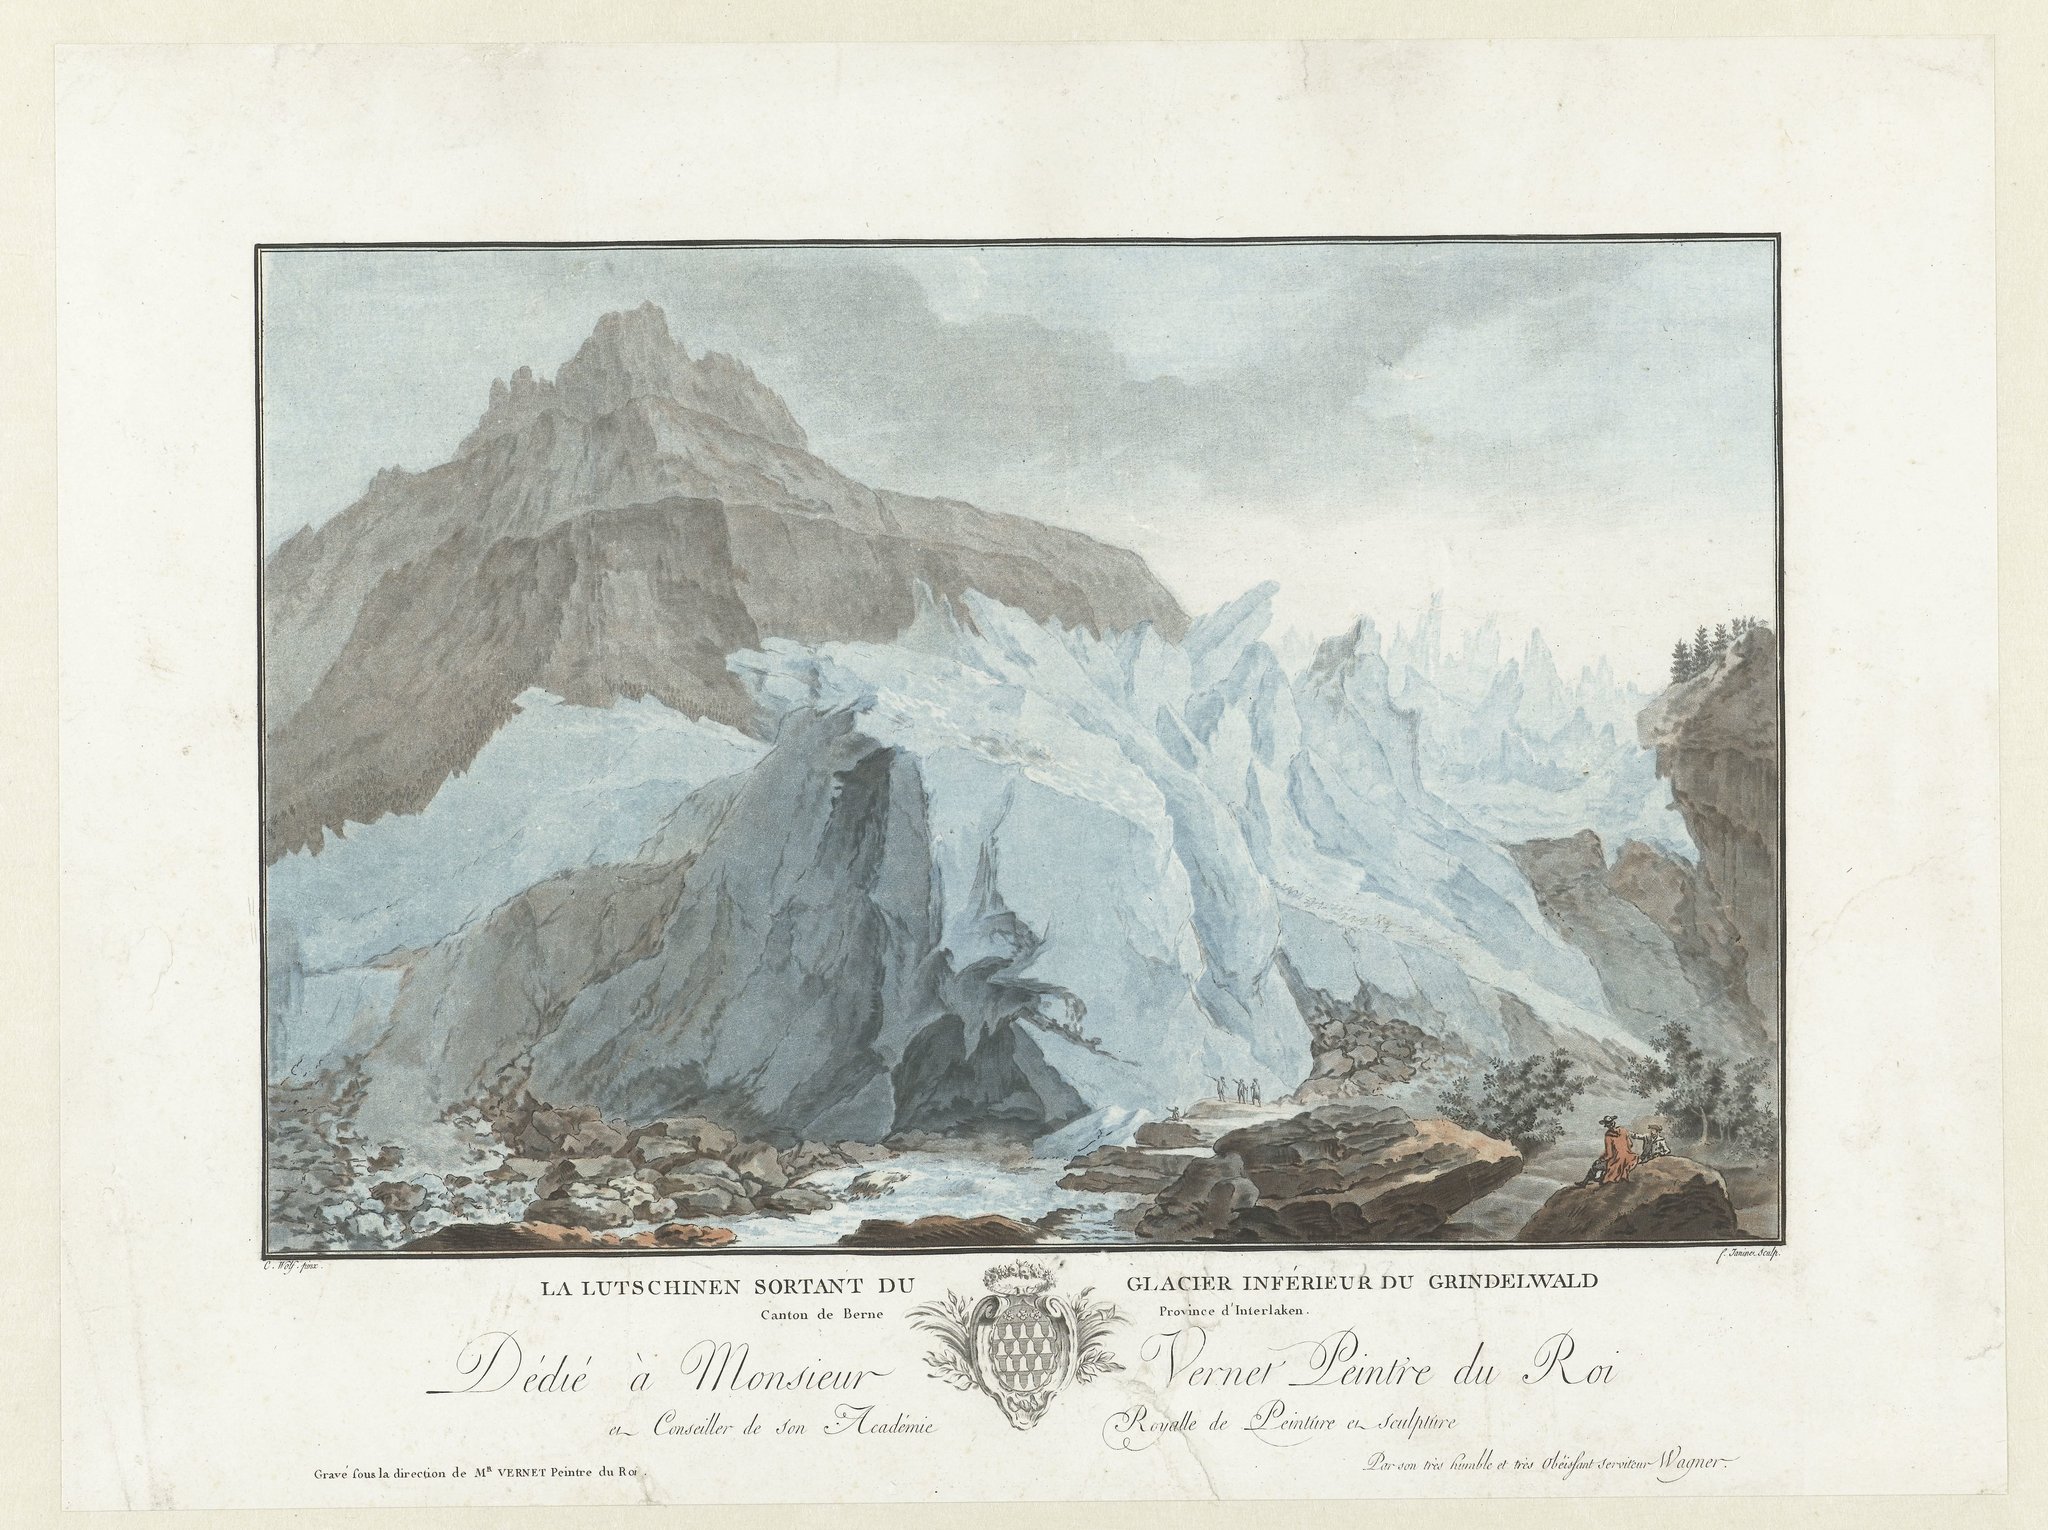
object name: print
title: Vues remarquables des montagnes de la Suisse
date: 1762-1785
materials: paper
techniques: etching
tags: glacier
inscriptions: collector's mark: Lugt 2228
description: Mogelijk afkomstig uit de serie uitgegeven door J. Yntema te Amsterdam in 1785. Er bestaat een prent gesigneerd met "Descourtis sculp" die precies hetzelfde is.